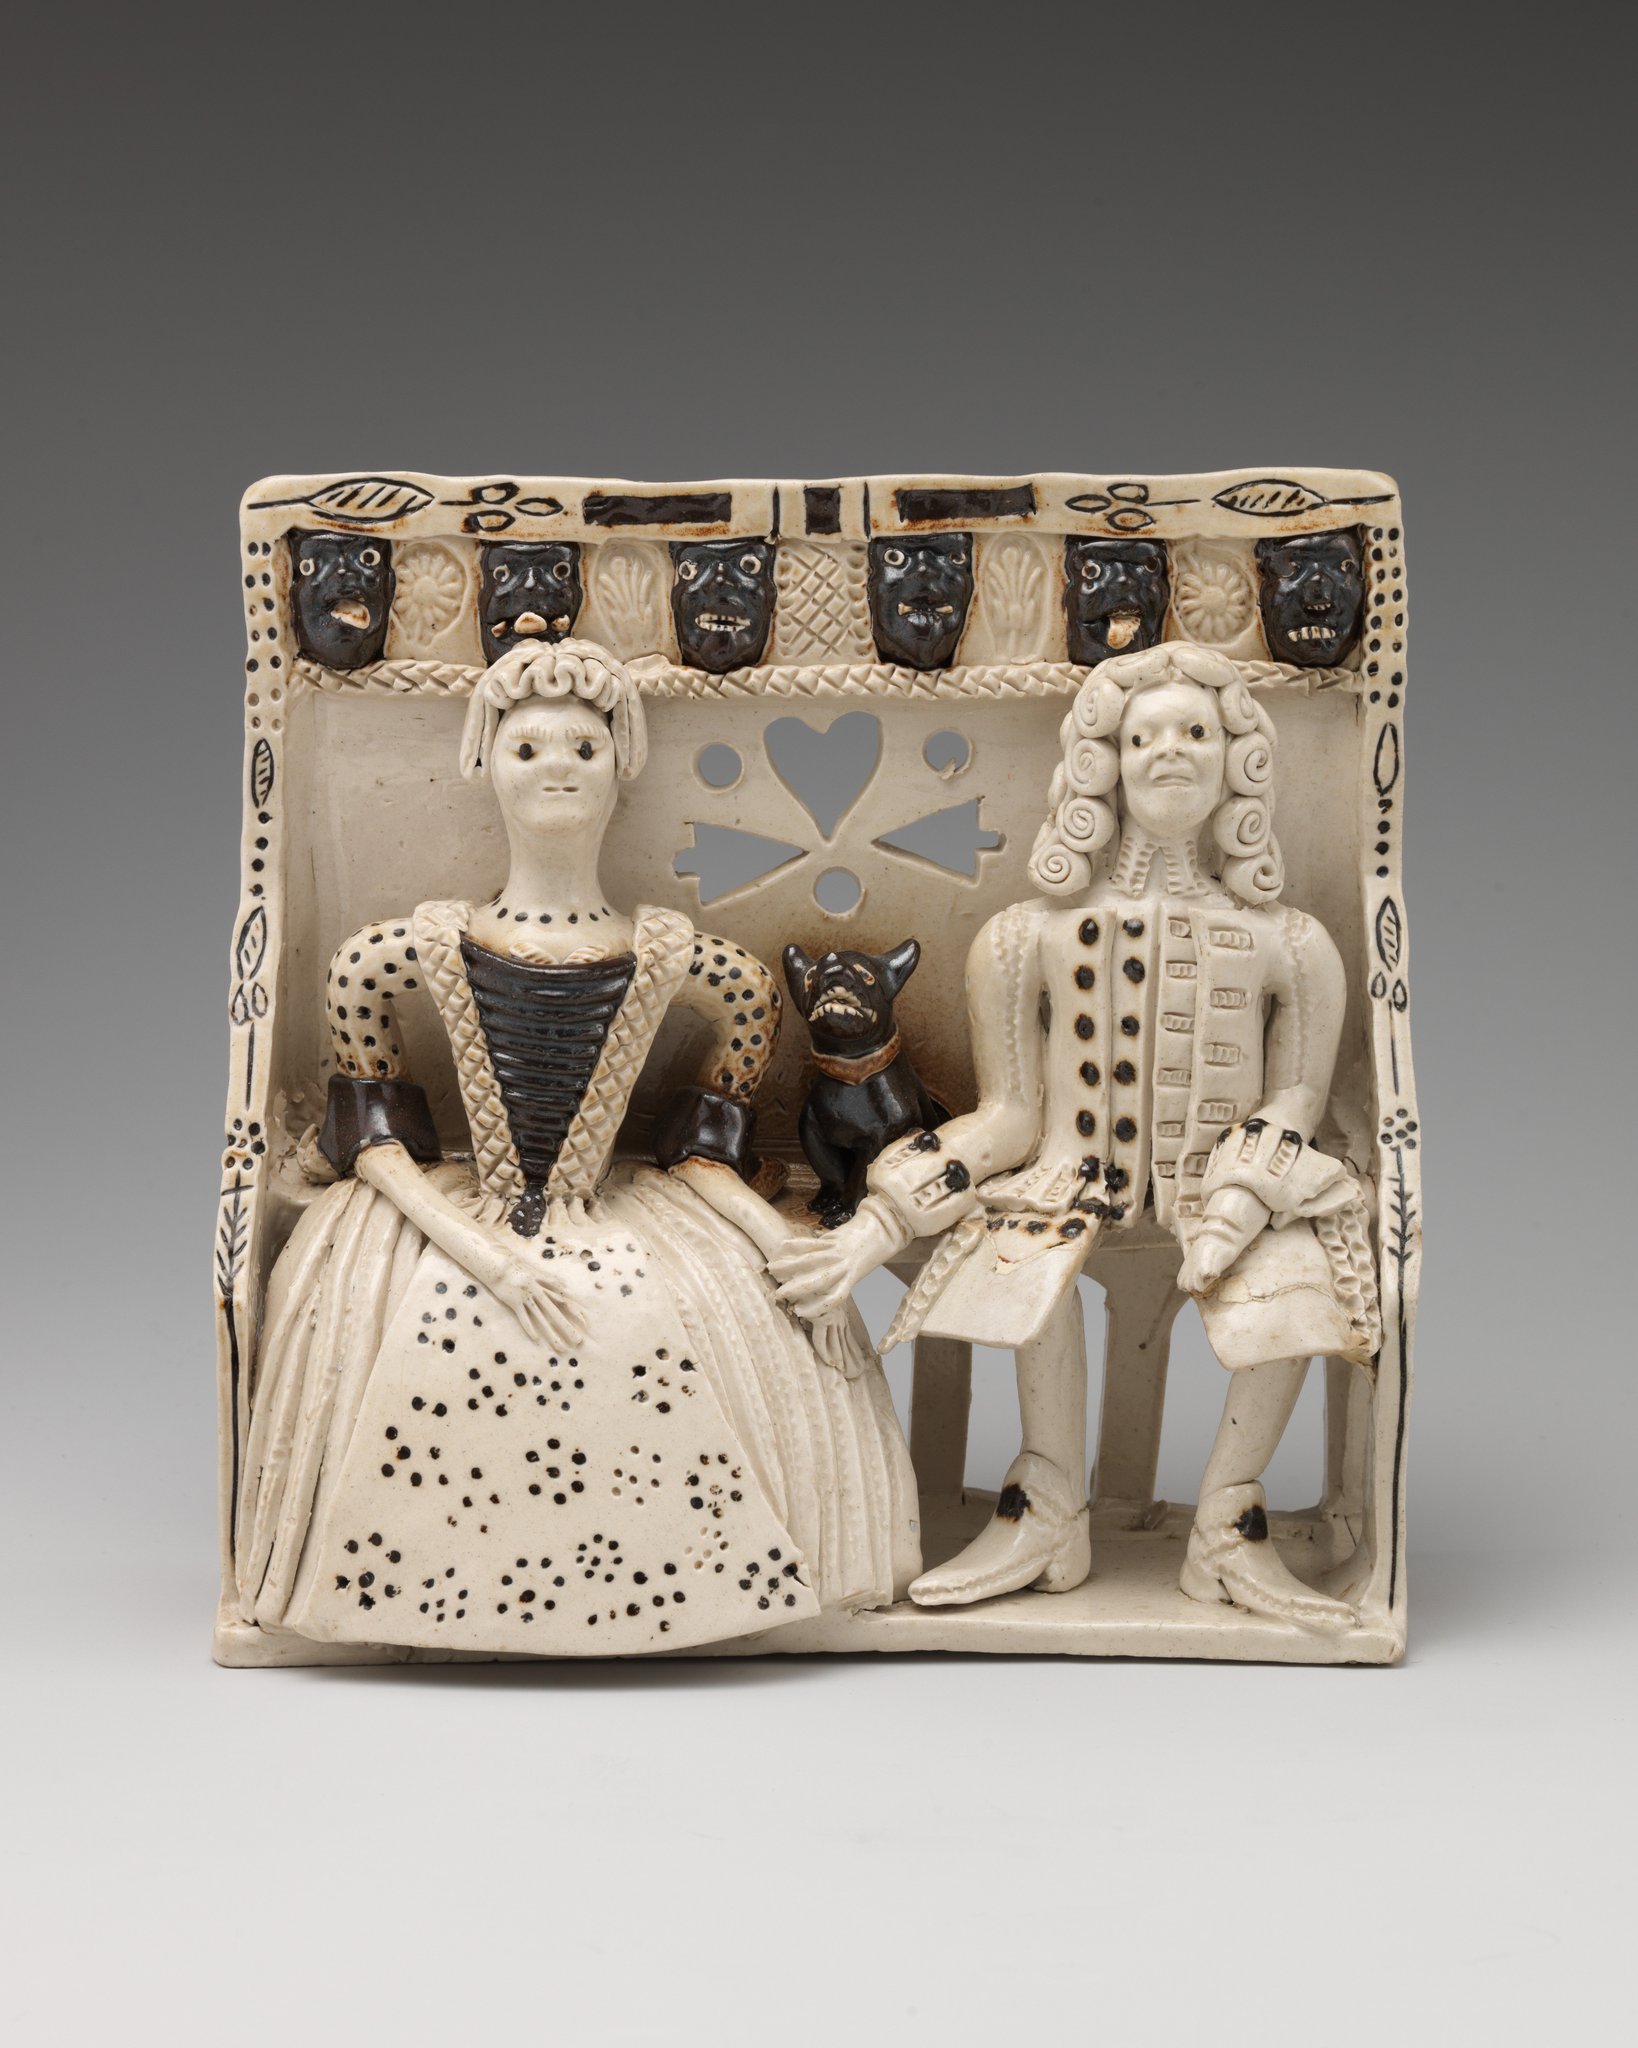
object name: figure group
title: Pew group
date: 1745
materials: stoneware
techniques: salt glaze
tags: couples,men,women,dogs,flowers,benches